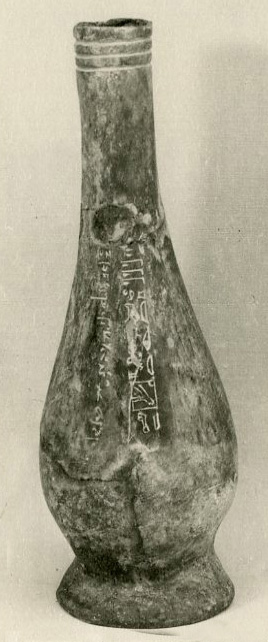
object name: bottle, votive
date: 304-30 BCE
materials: silver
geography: egypt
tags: hieroglyphs